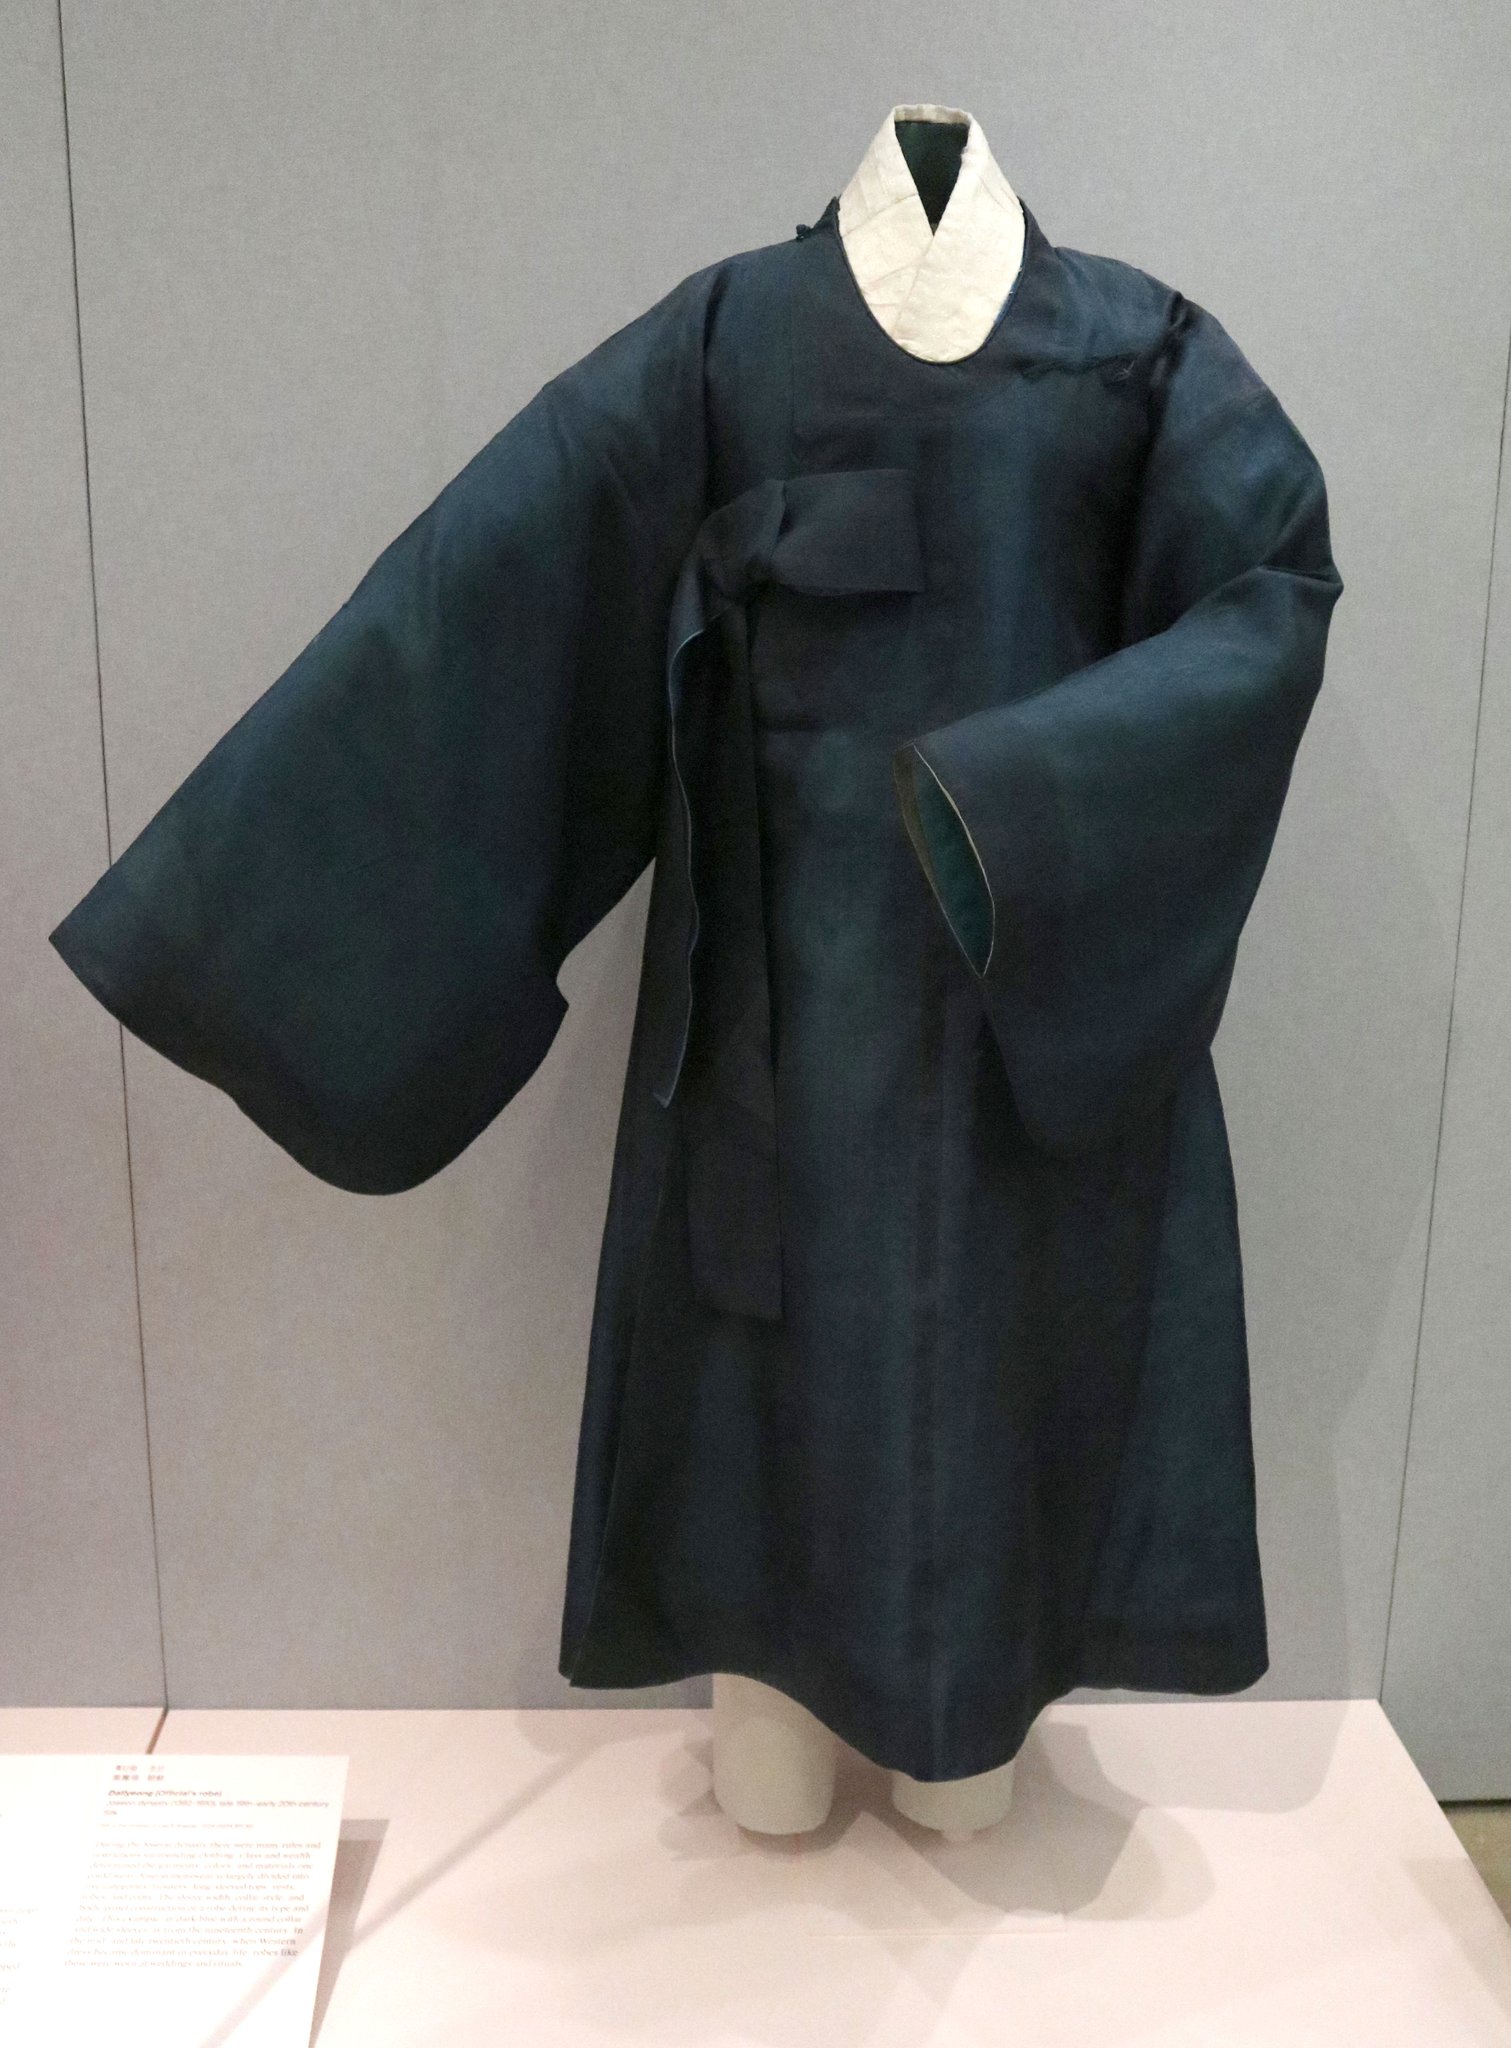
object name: robe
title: Dallyeong (Official’s robe)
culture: korean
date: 1867-1933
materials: silk